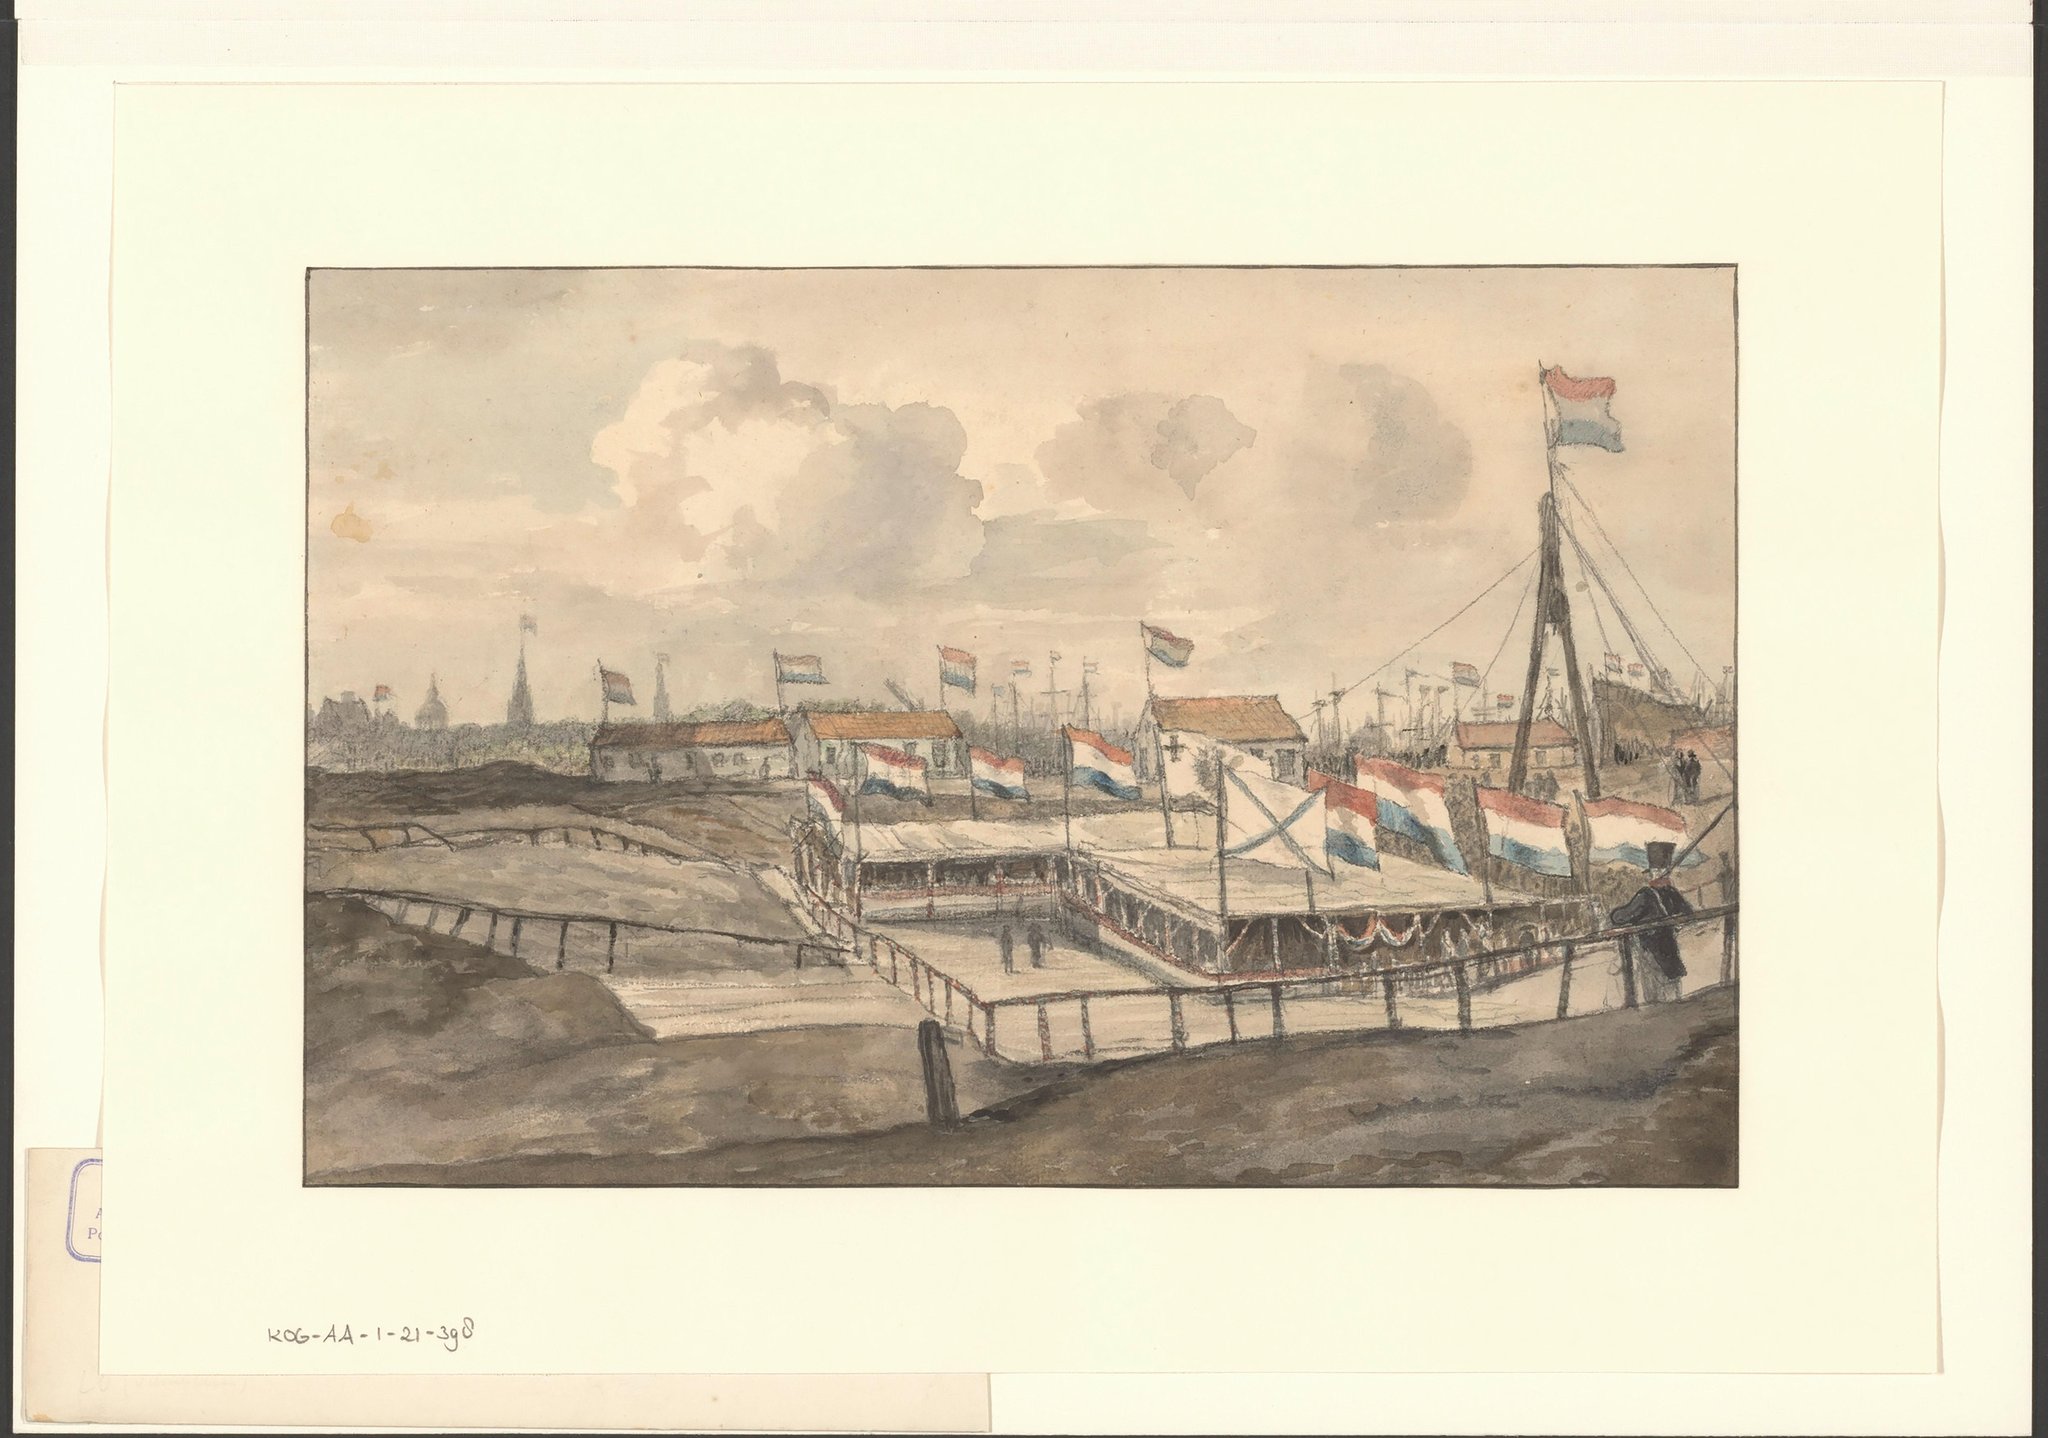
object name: drawing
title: Gezicht op een feesttent opgericht ter ere van de eerste steenlegging van de Oosterdoksluis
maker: gerrit lamberts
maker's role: bookseller, draughtsman, print maker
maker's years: 1776-1850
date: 1806-1830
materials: chalk, paper, watercolor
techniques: brush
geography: amsterdam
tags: sluice, weir, city-view in general; 'veduta', flag, colours (as symbol of the state, etc.)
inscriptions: inscription: ‘De tent in de put van de Oosterdoksluis / bij de eerste steenlegging, 11 Juni 1830’, collector's mark: ‘21’ Lugt 1641b, collector's mark: ‘2481’ Lugt 1811, inscription: ‘Port. 21-398’